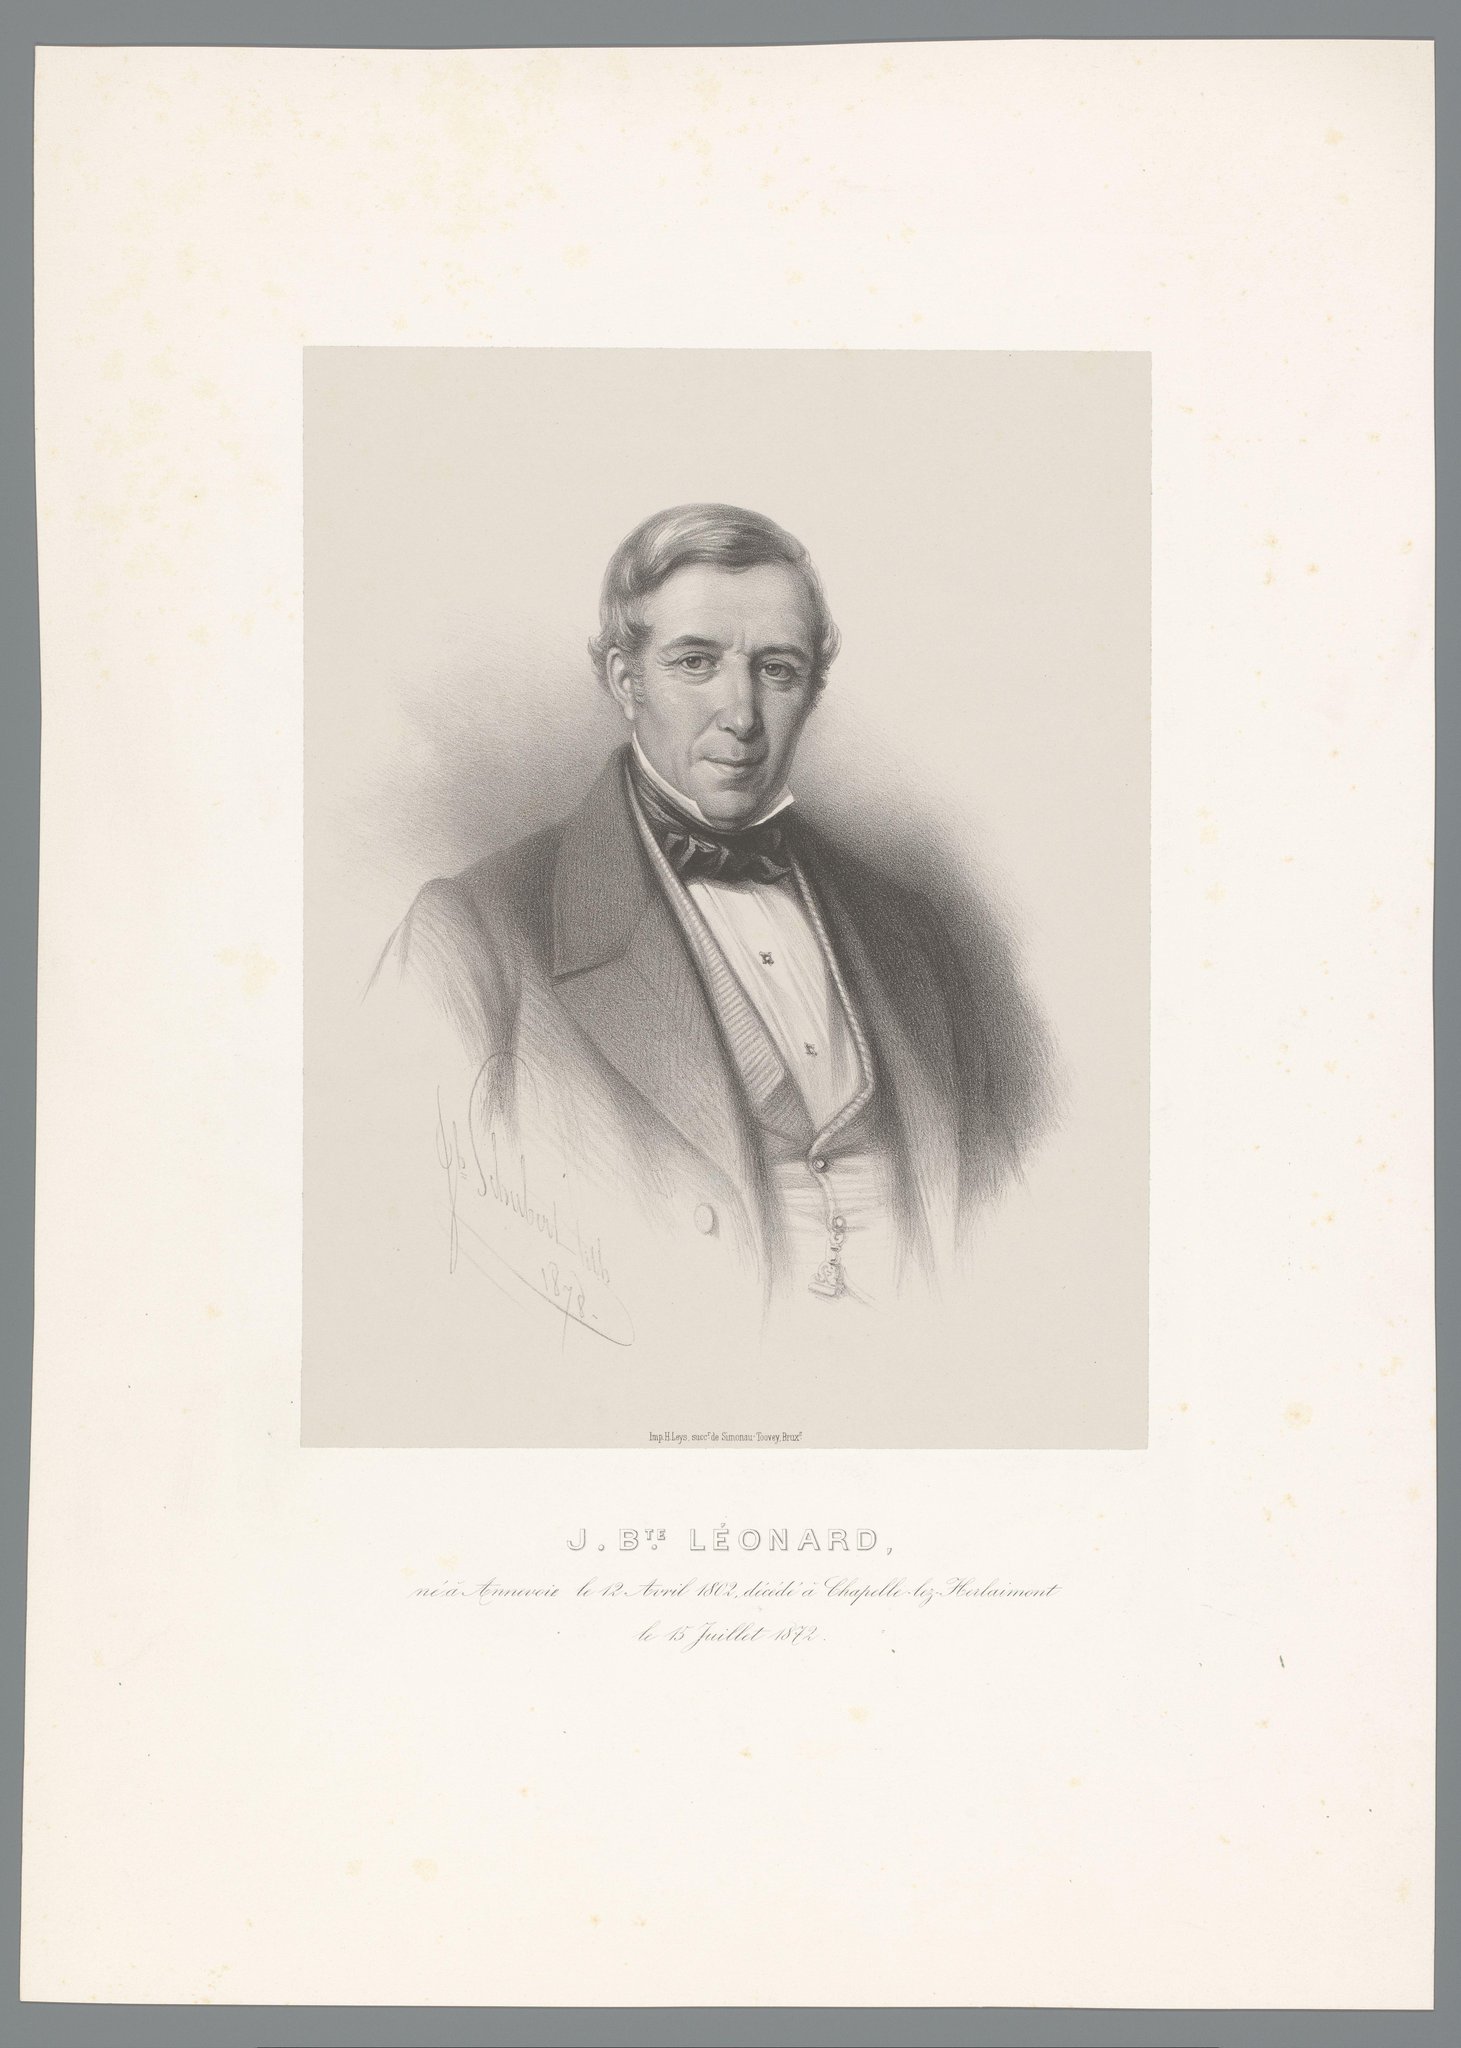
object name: print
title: J. B.te Léonard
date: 1878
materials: paper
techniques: lithograph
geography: brussels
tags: historical persons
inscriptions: collector's mark: Lugt 2228